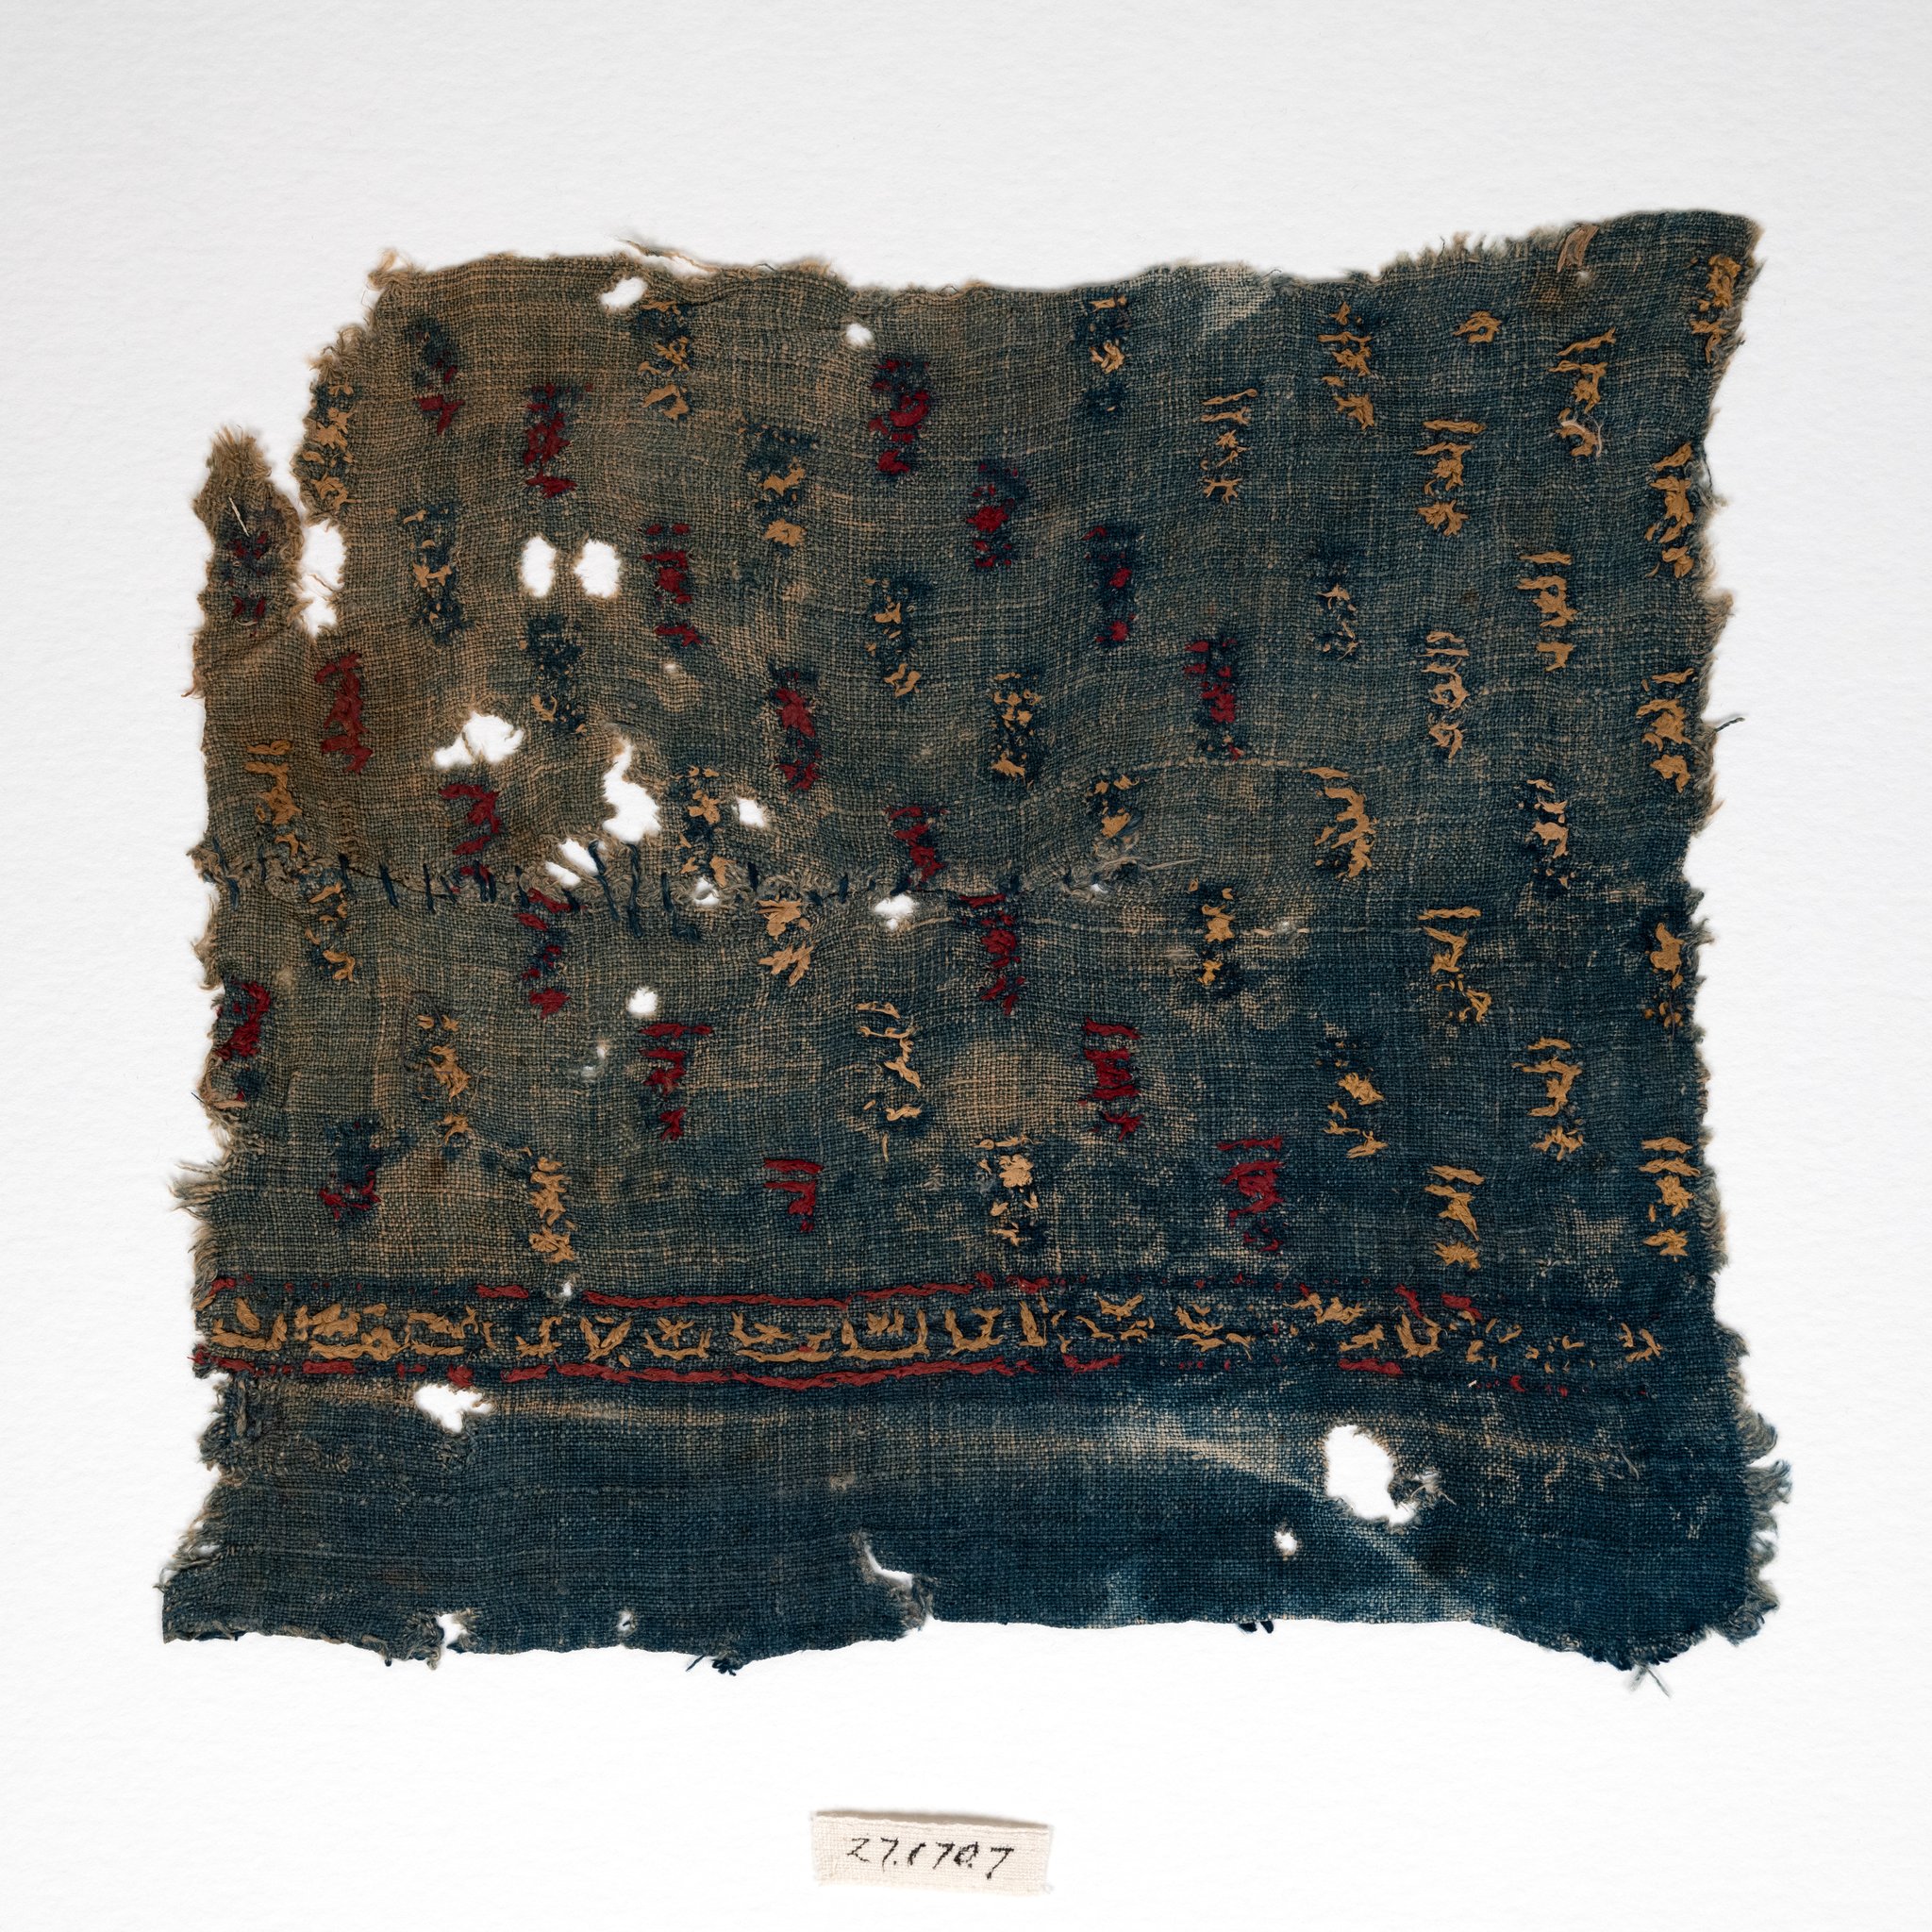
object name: textile fragment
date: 1201-1400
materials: linen, silk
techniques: embroidery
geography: egypt